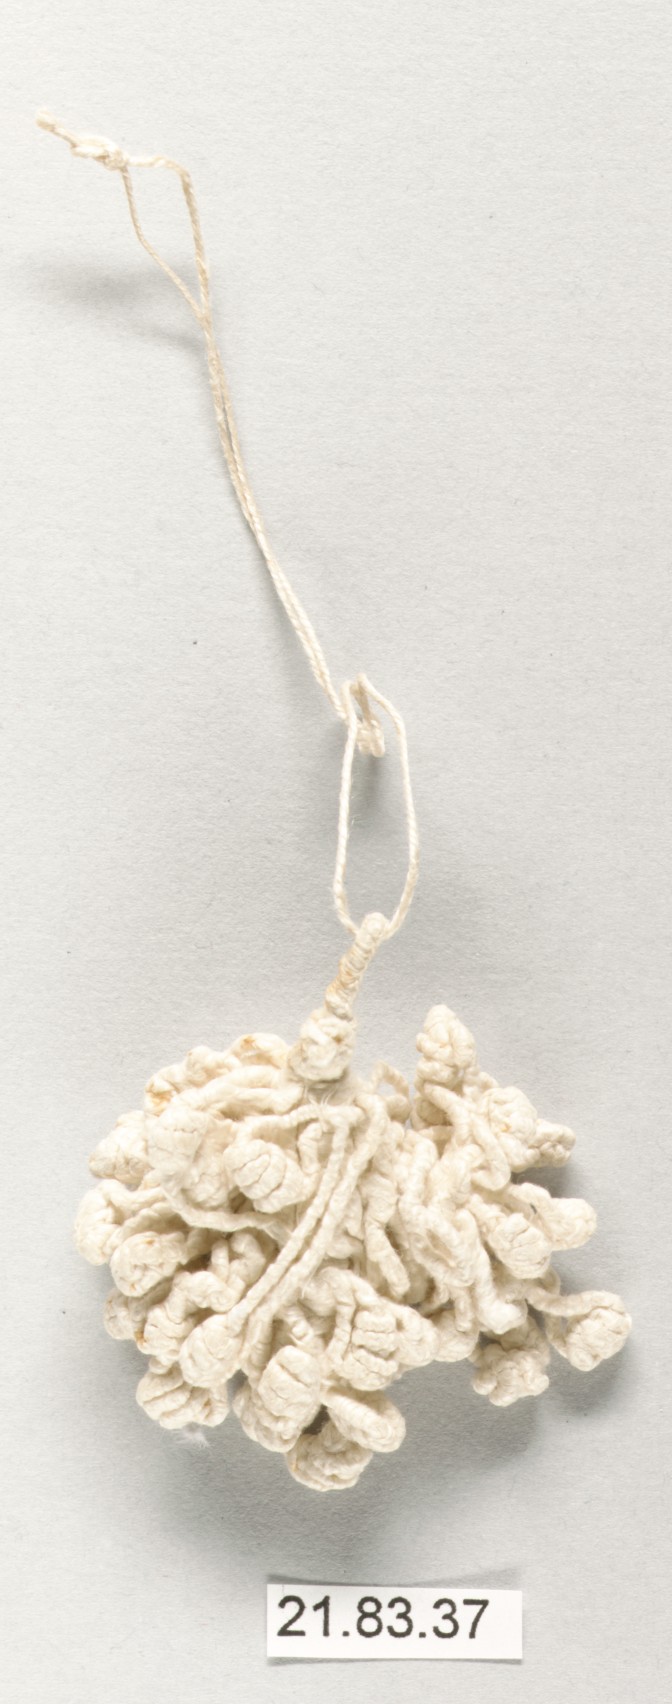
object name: tassel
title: Pair of tassels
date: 1601-1700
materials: linen